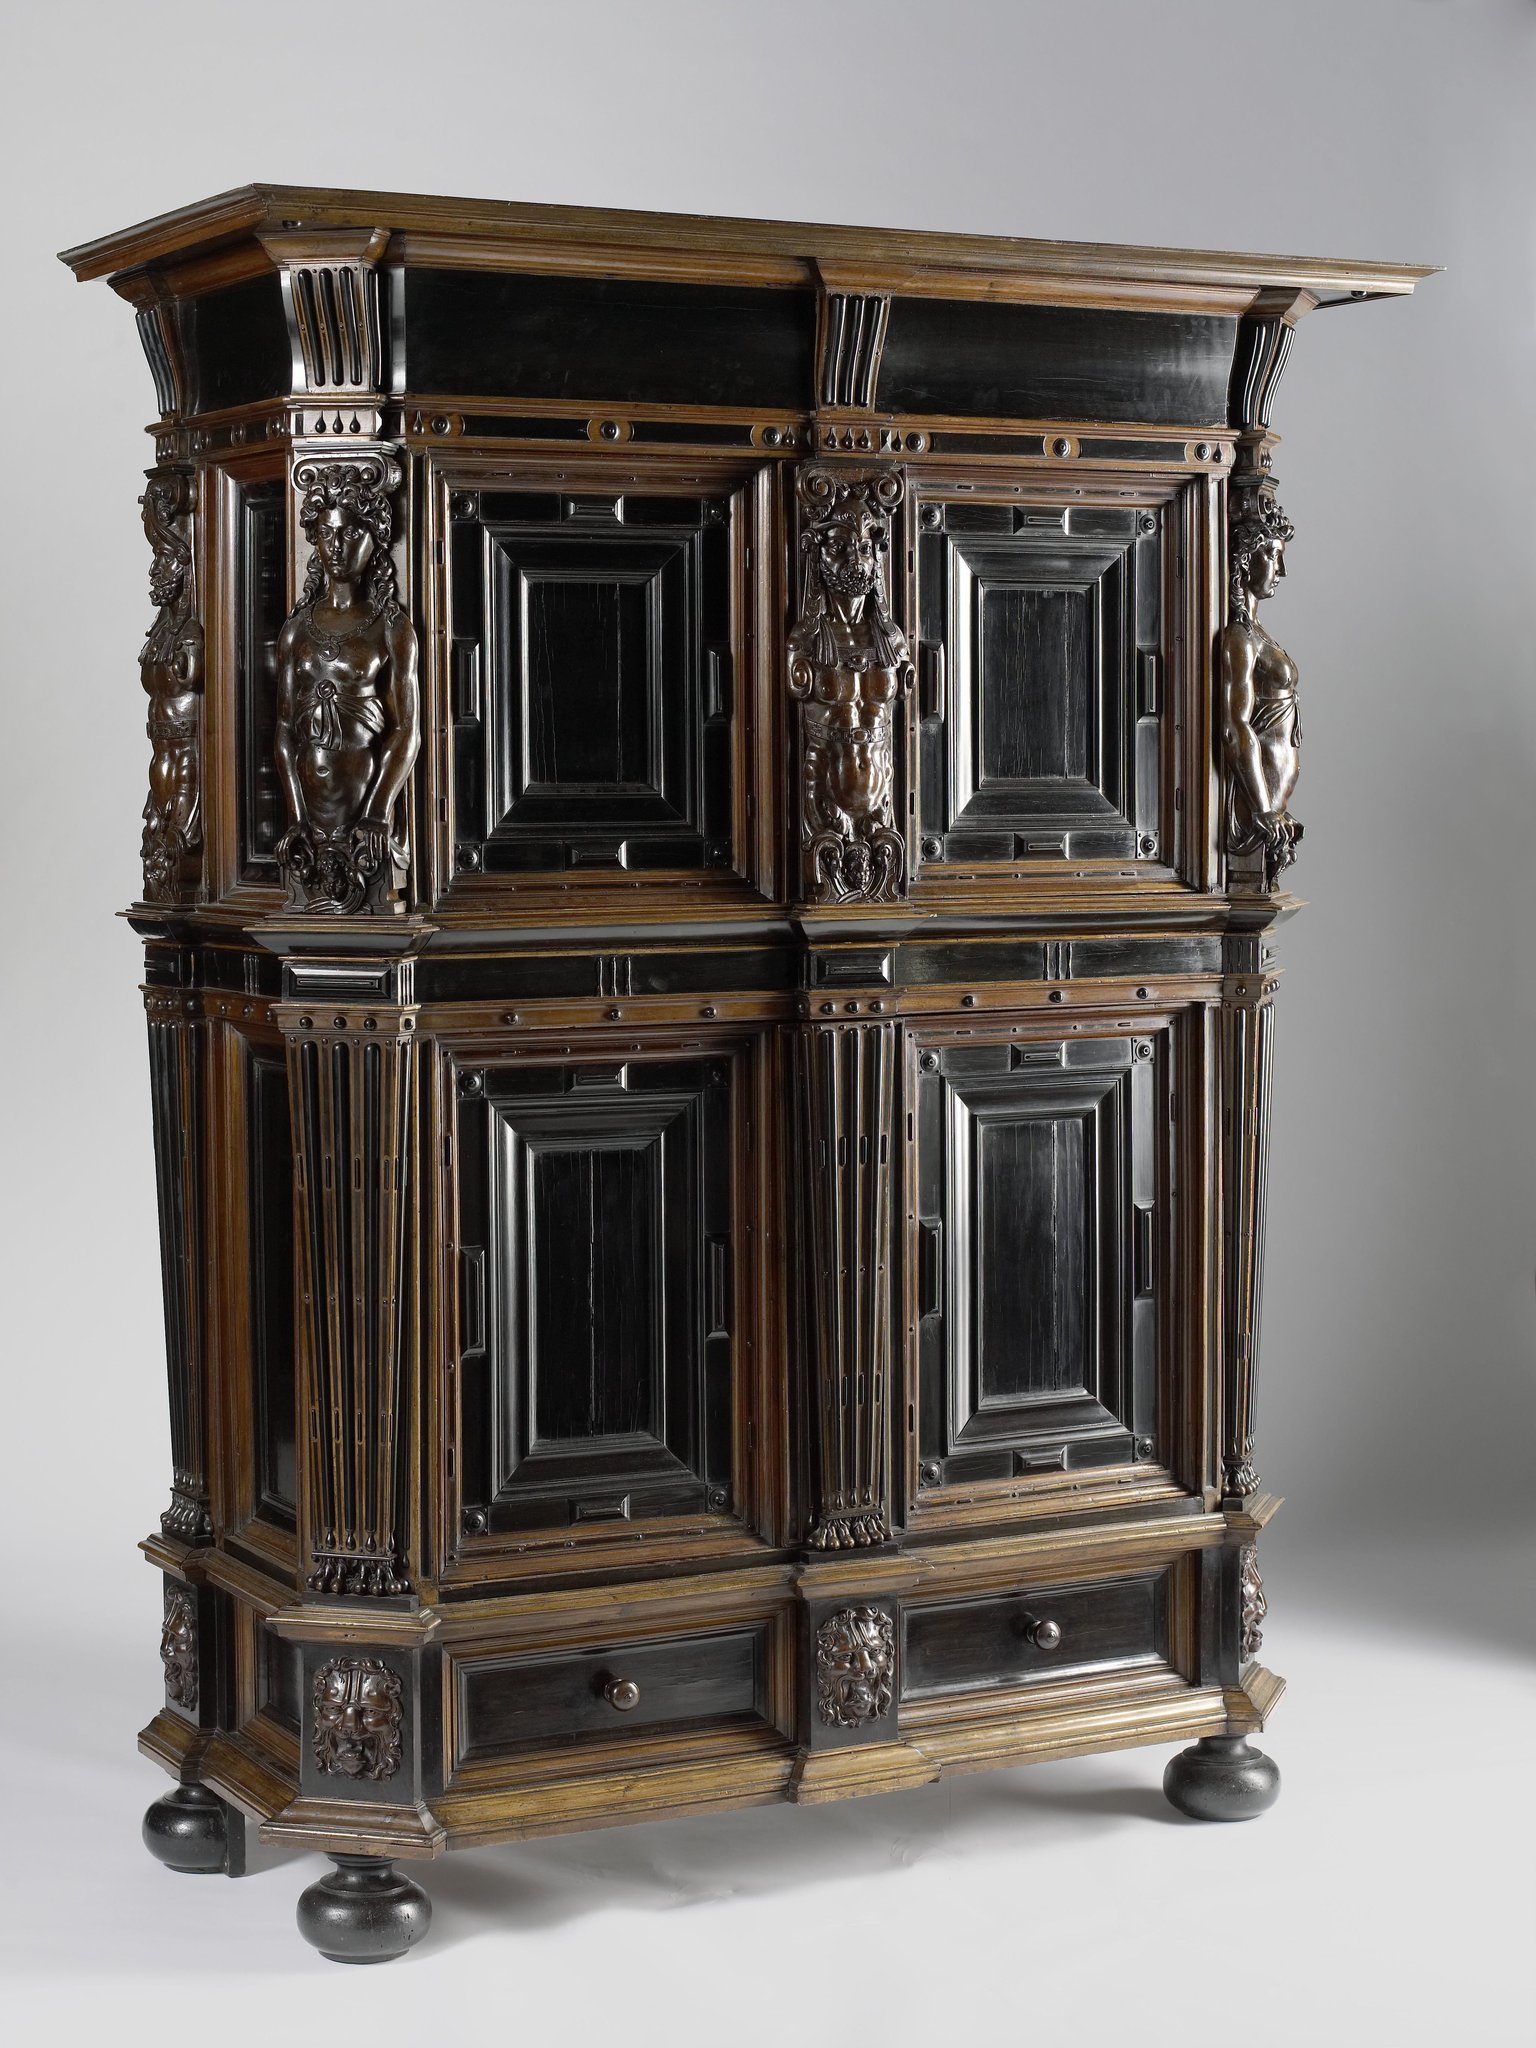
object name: case furniture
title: Cupboard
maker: Anonymous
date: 1630-1640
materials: wood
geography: amsterdam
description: The decoration of this ornamental cupboard refers to the architecture of Greek and Roman antiquity. It is detailed like a building. The corners and the central stile are formed as pilasters crowned by human bodies, known as herms. The owner of such a piece of furniture demonstrated his interest in classical culture, considered to be the fountainhead of western civilization.